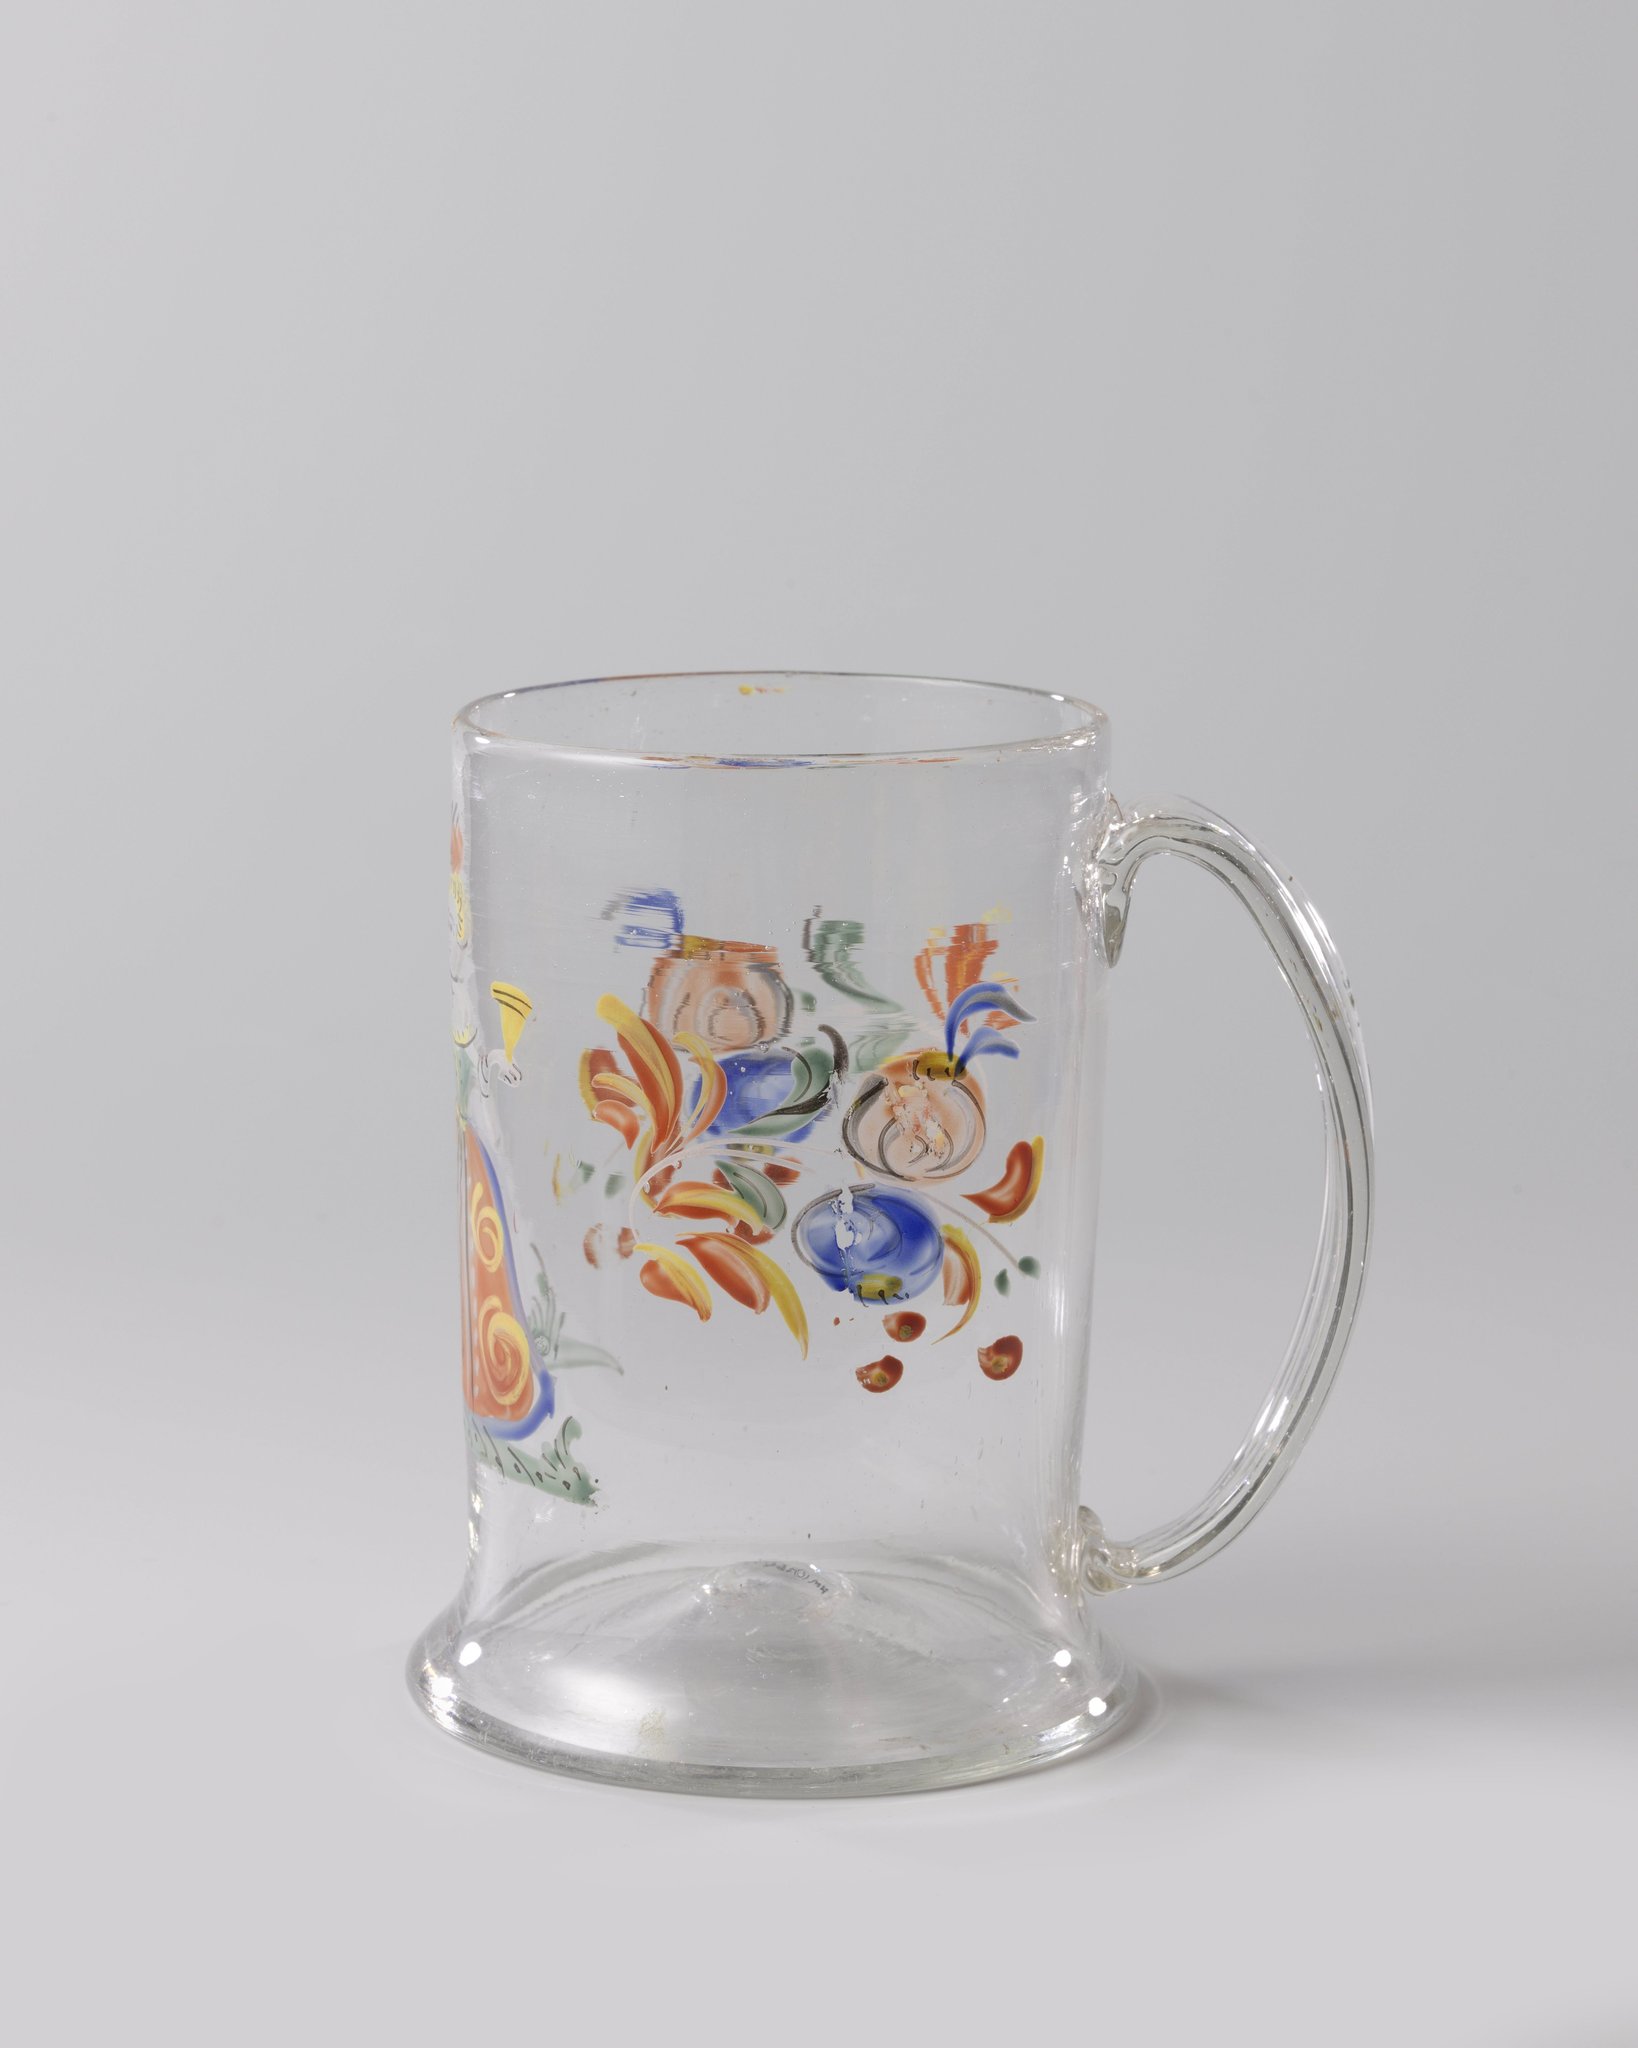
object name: humpen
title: Humpen met een vrouw die een glas heft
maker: Anonymous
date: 1700-1800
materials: glass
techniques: glassblowing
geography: central europe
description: Licht ingestoken bodem, gladde standring, cylindervormig lichaam en c-vormig oor. Op het lichaam in rood, wit, blauw, geel, groen en zwart een vrouw in elegant toilet, die met de linker hand een glas heft. Ter weerskanten een bloemtak.